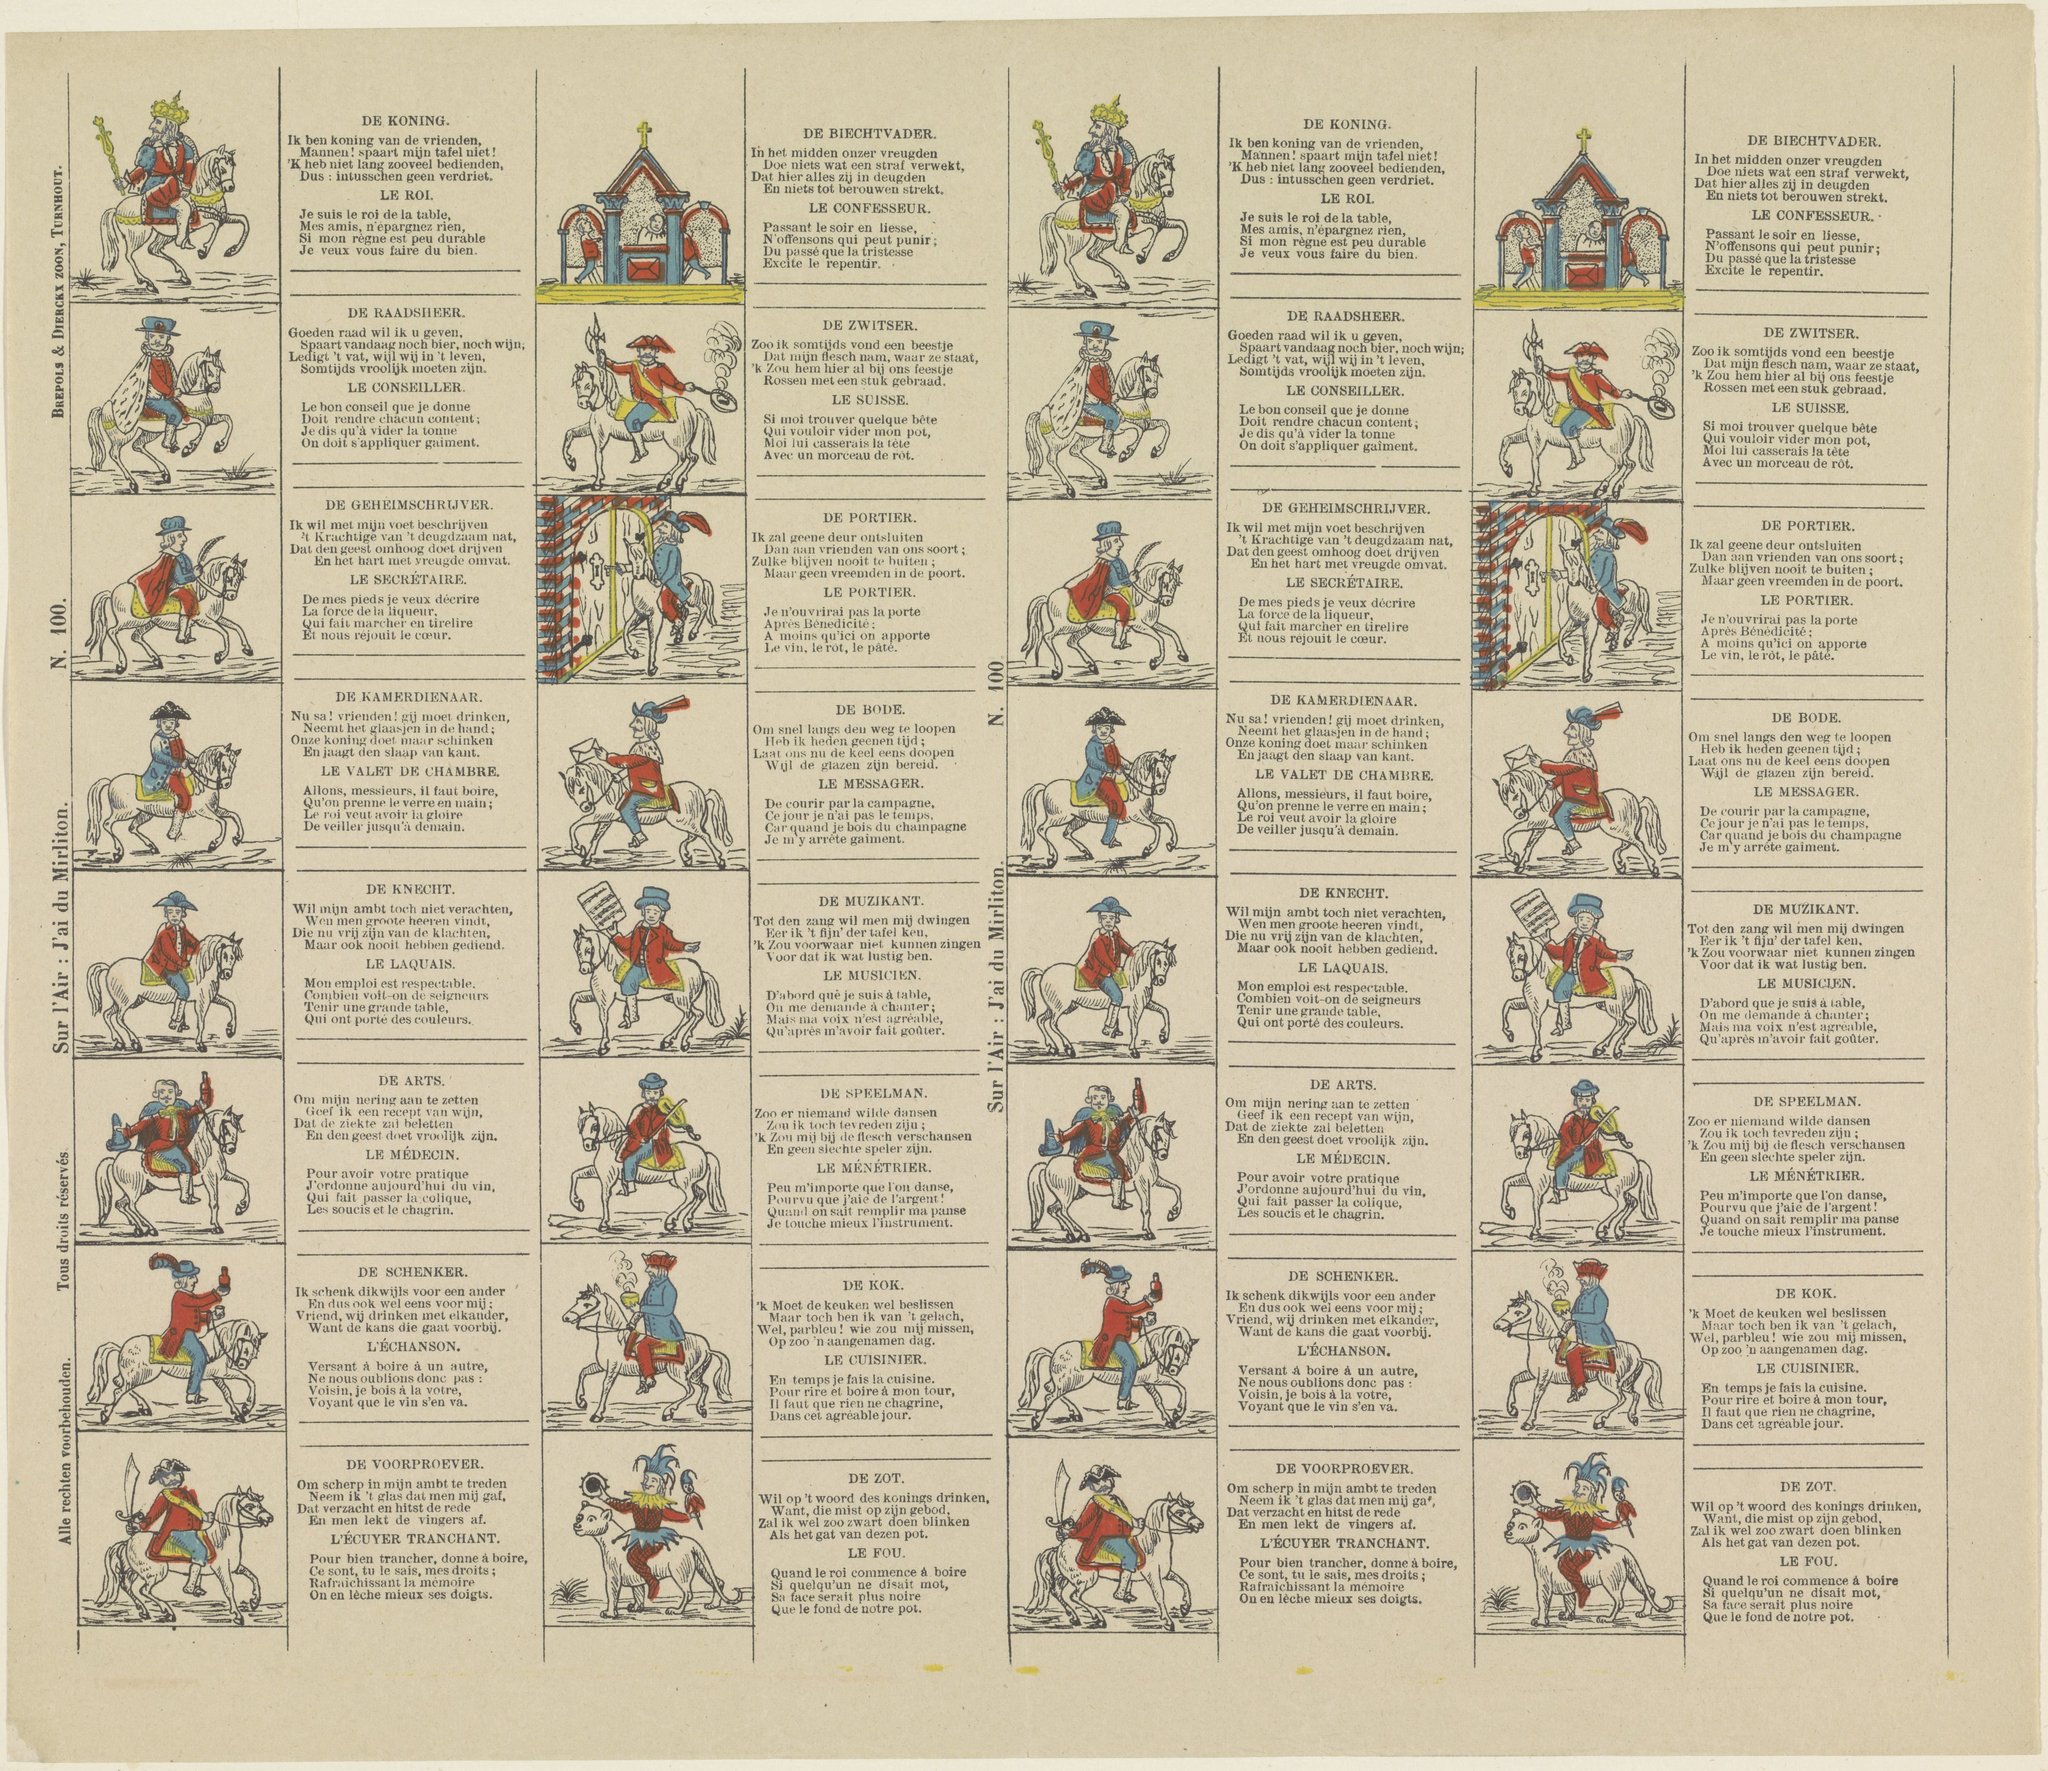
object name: print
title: Sur l'air: J'ai du Mirliton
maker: Anonymous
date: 1833-1911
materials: paper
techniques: lithograph, letterpress printing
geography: turnhout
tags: twelfth night, usually falling on the eve of january 6, royal household; courtiers, retinue, train, epiphany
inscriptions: collector's mark: Lugt 2760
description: Blad met 32 voorstellingen (driekoningenbriefjes) van verschillende functies binnen het hof, waaronder een raadsman, een proever en een portier. Rechts naast elke afbeelding een vierregelig vers in het Nederlands en in het Frans. Genummerd midden links: n. 100.